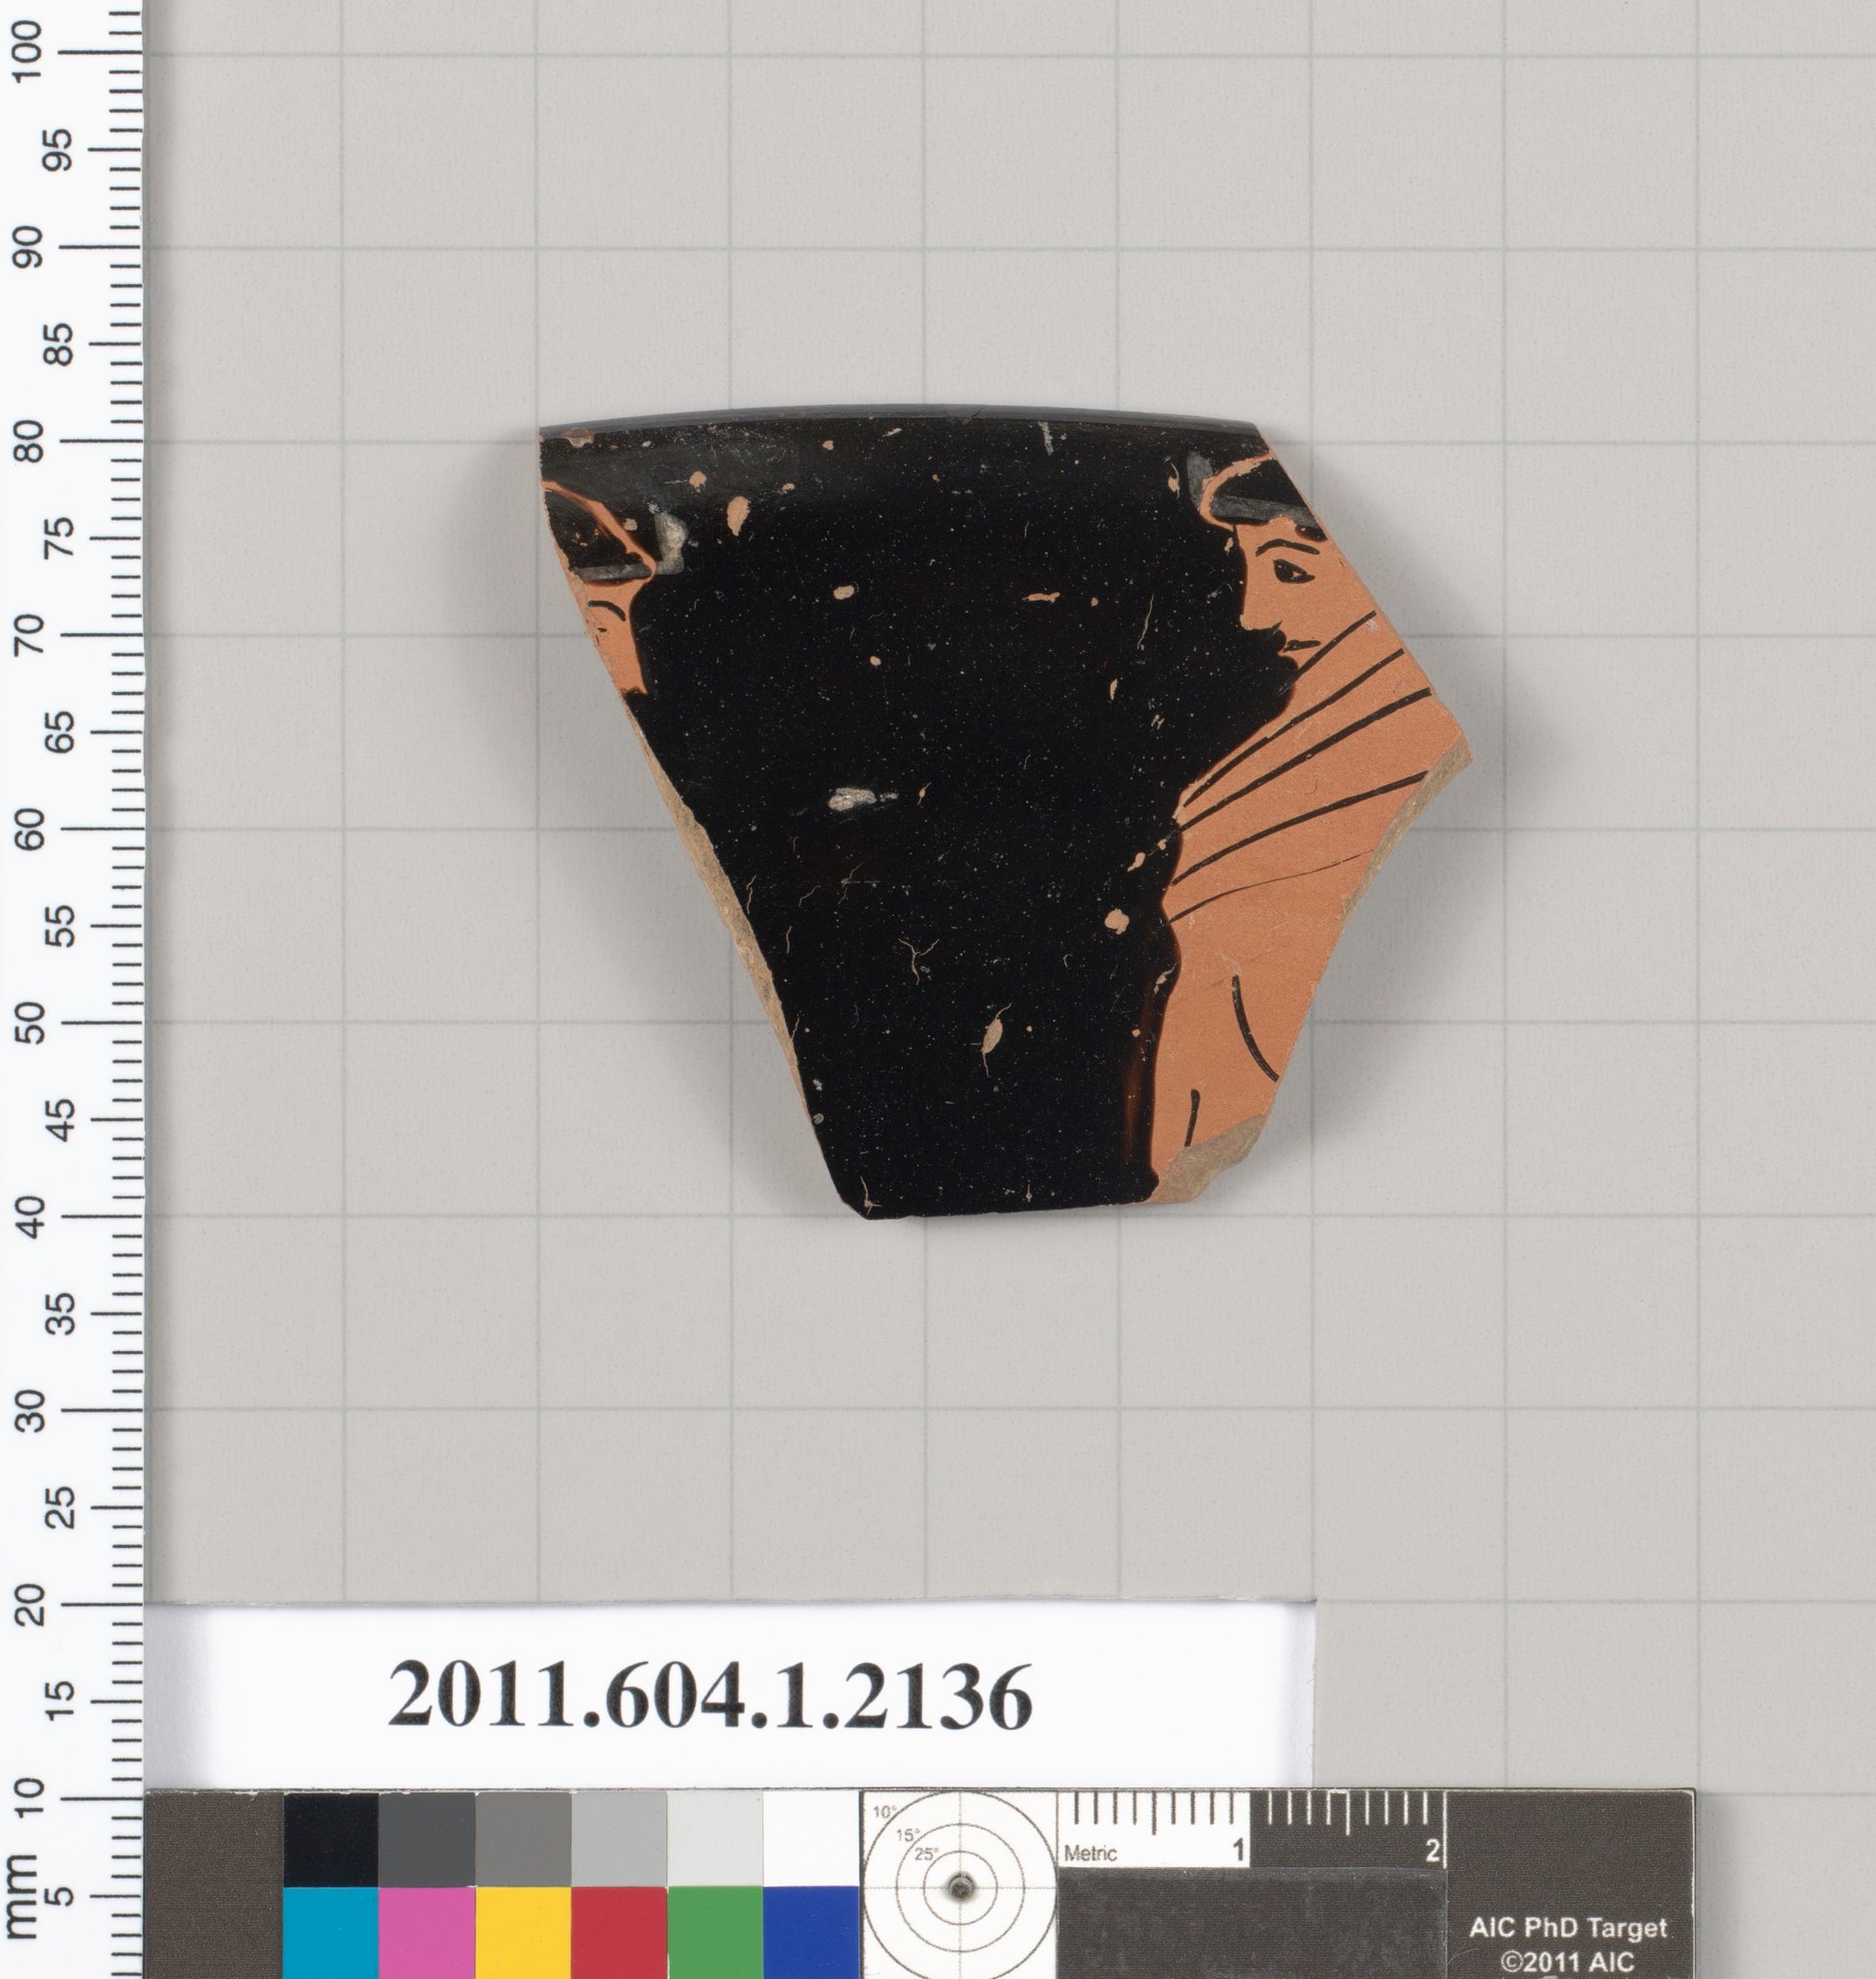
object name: kylix fragment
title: Terracotta rim fragment of a kylix (drinking cup)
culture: greek, attic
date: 475-451 BCE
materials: terracotta